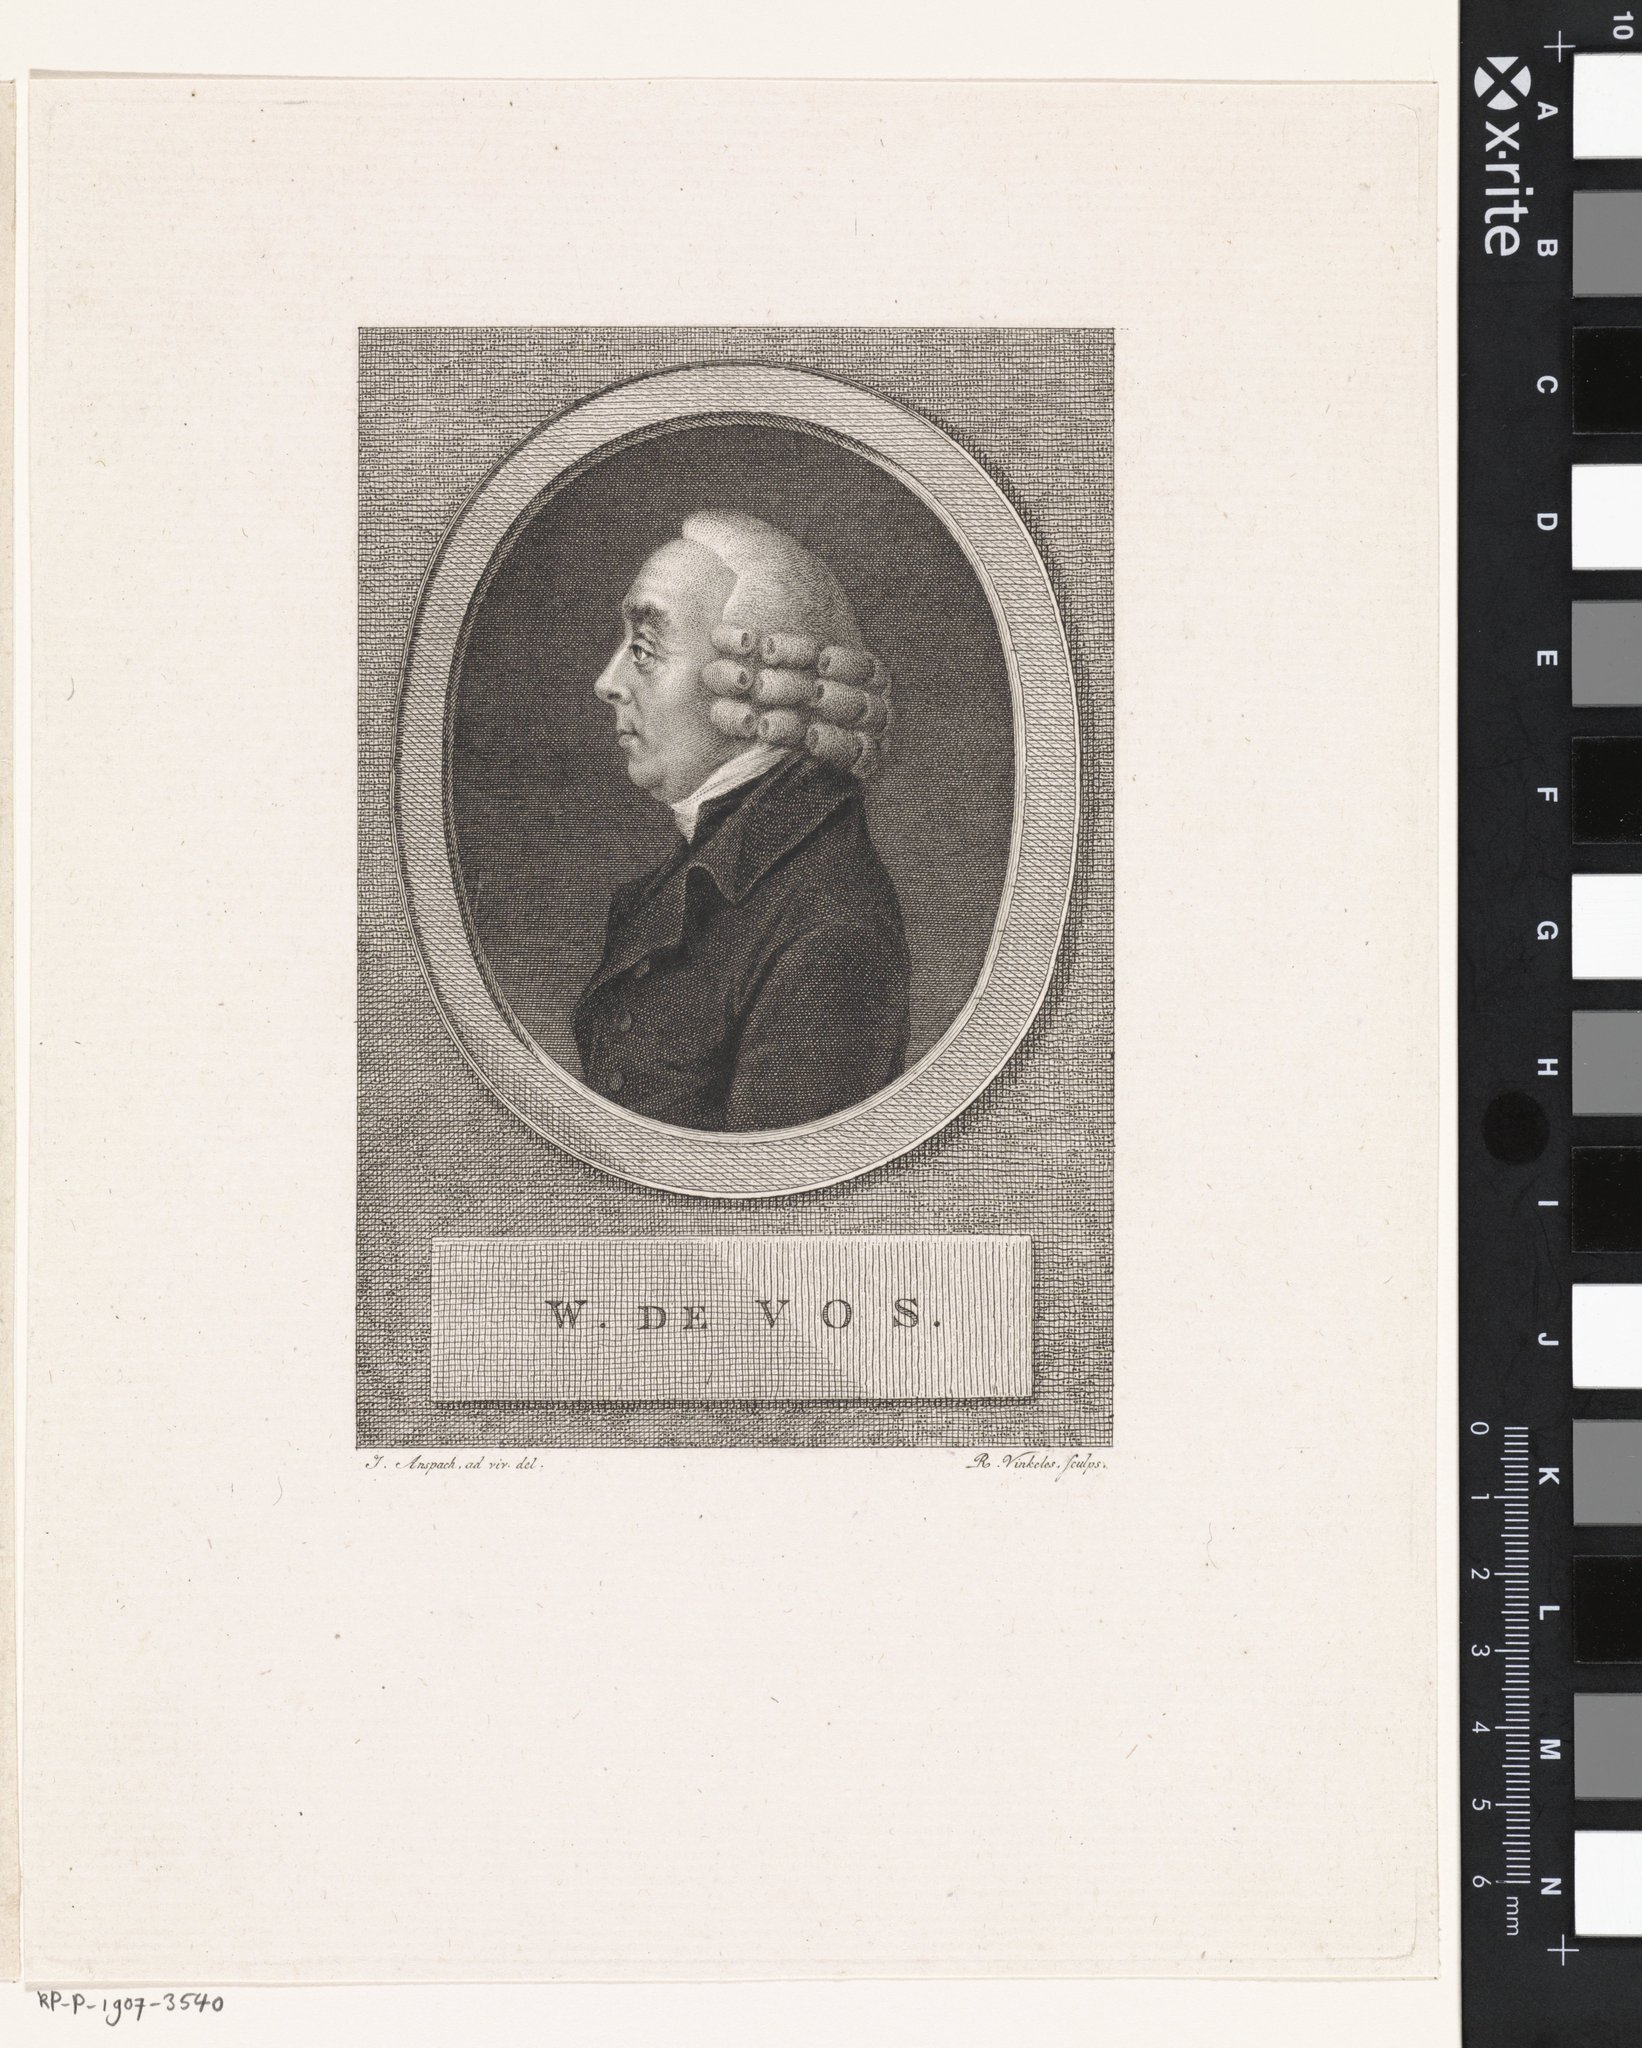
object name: print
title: Portret van Willem de Vos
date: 1751-1816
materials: paper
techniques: engraving, etching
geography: amsterdam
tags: amsterdam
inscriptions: collector's mark: Lugt 2228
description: Portret van Willem de Vos, doopsgezinde predikant te Amsterdam.